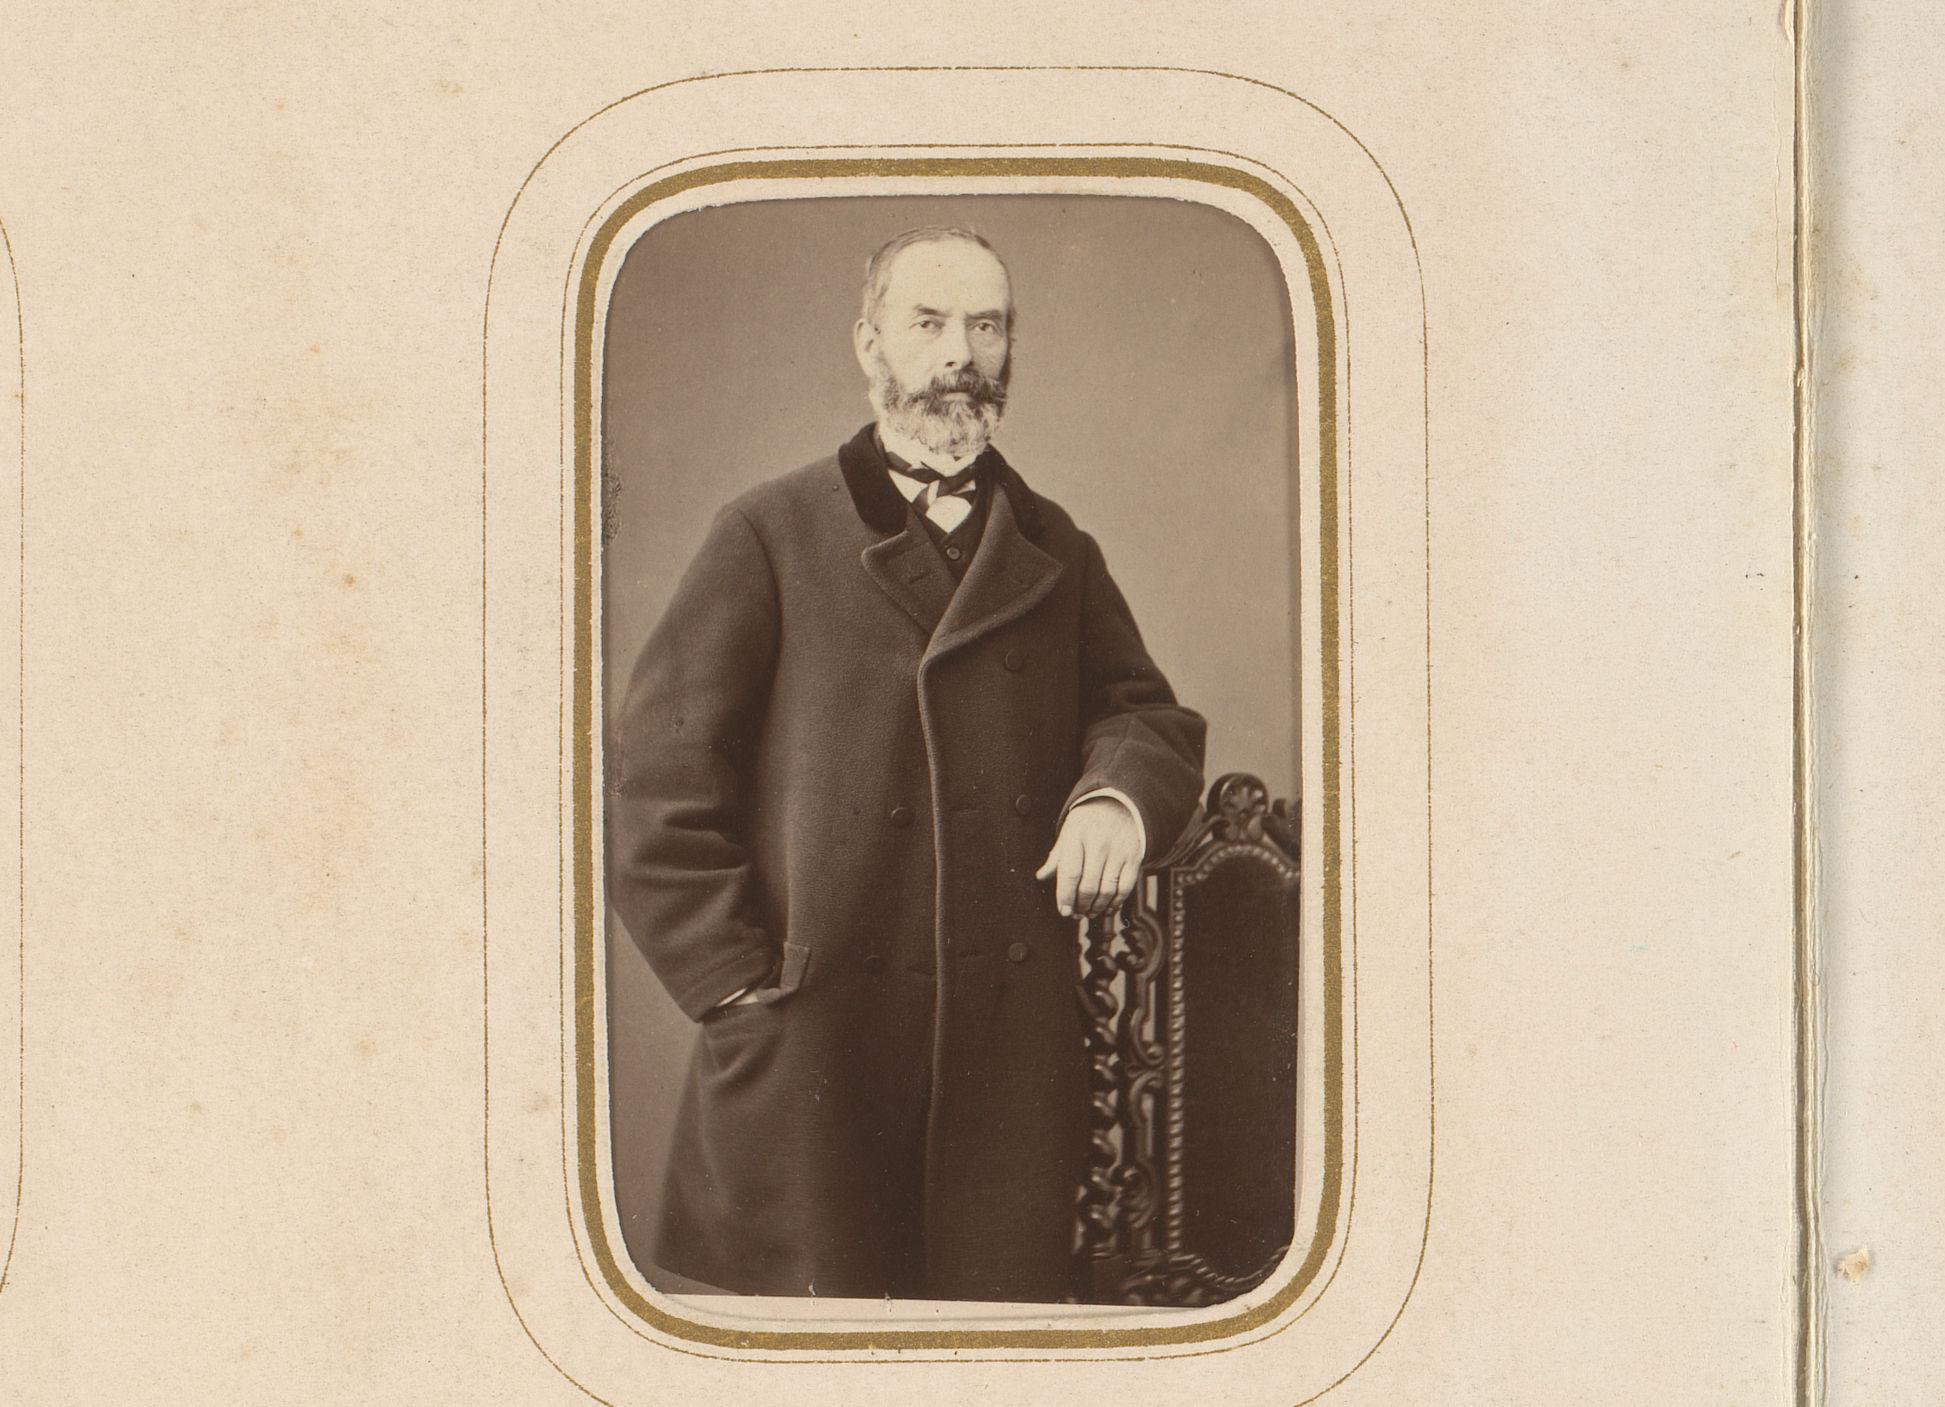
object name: photograph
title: Portret van een staande man met baard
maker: albert collard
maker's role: fotograaf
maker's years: 1838-1887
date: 1867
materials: cardboard, photographic support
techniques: albumen print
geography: paris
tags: historical persons, beard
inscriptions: inscription: ‘Collard Phot/ Des ponts & Chaussees’, inscription: ‘Expositions universelles 1855-1867/ Londres 1862/ Mention Honorable/ Atelier Central de Photographie/ Collard/ 39, Boulevart de Strasbourg/ Paris’